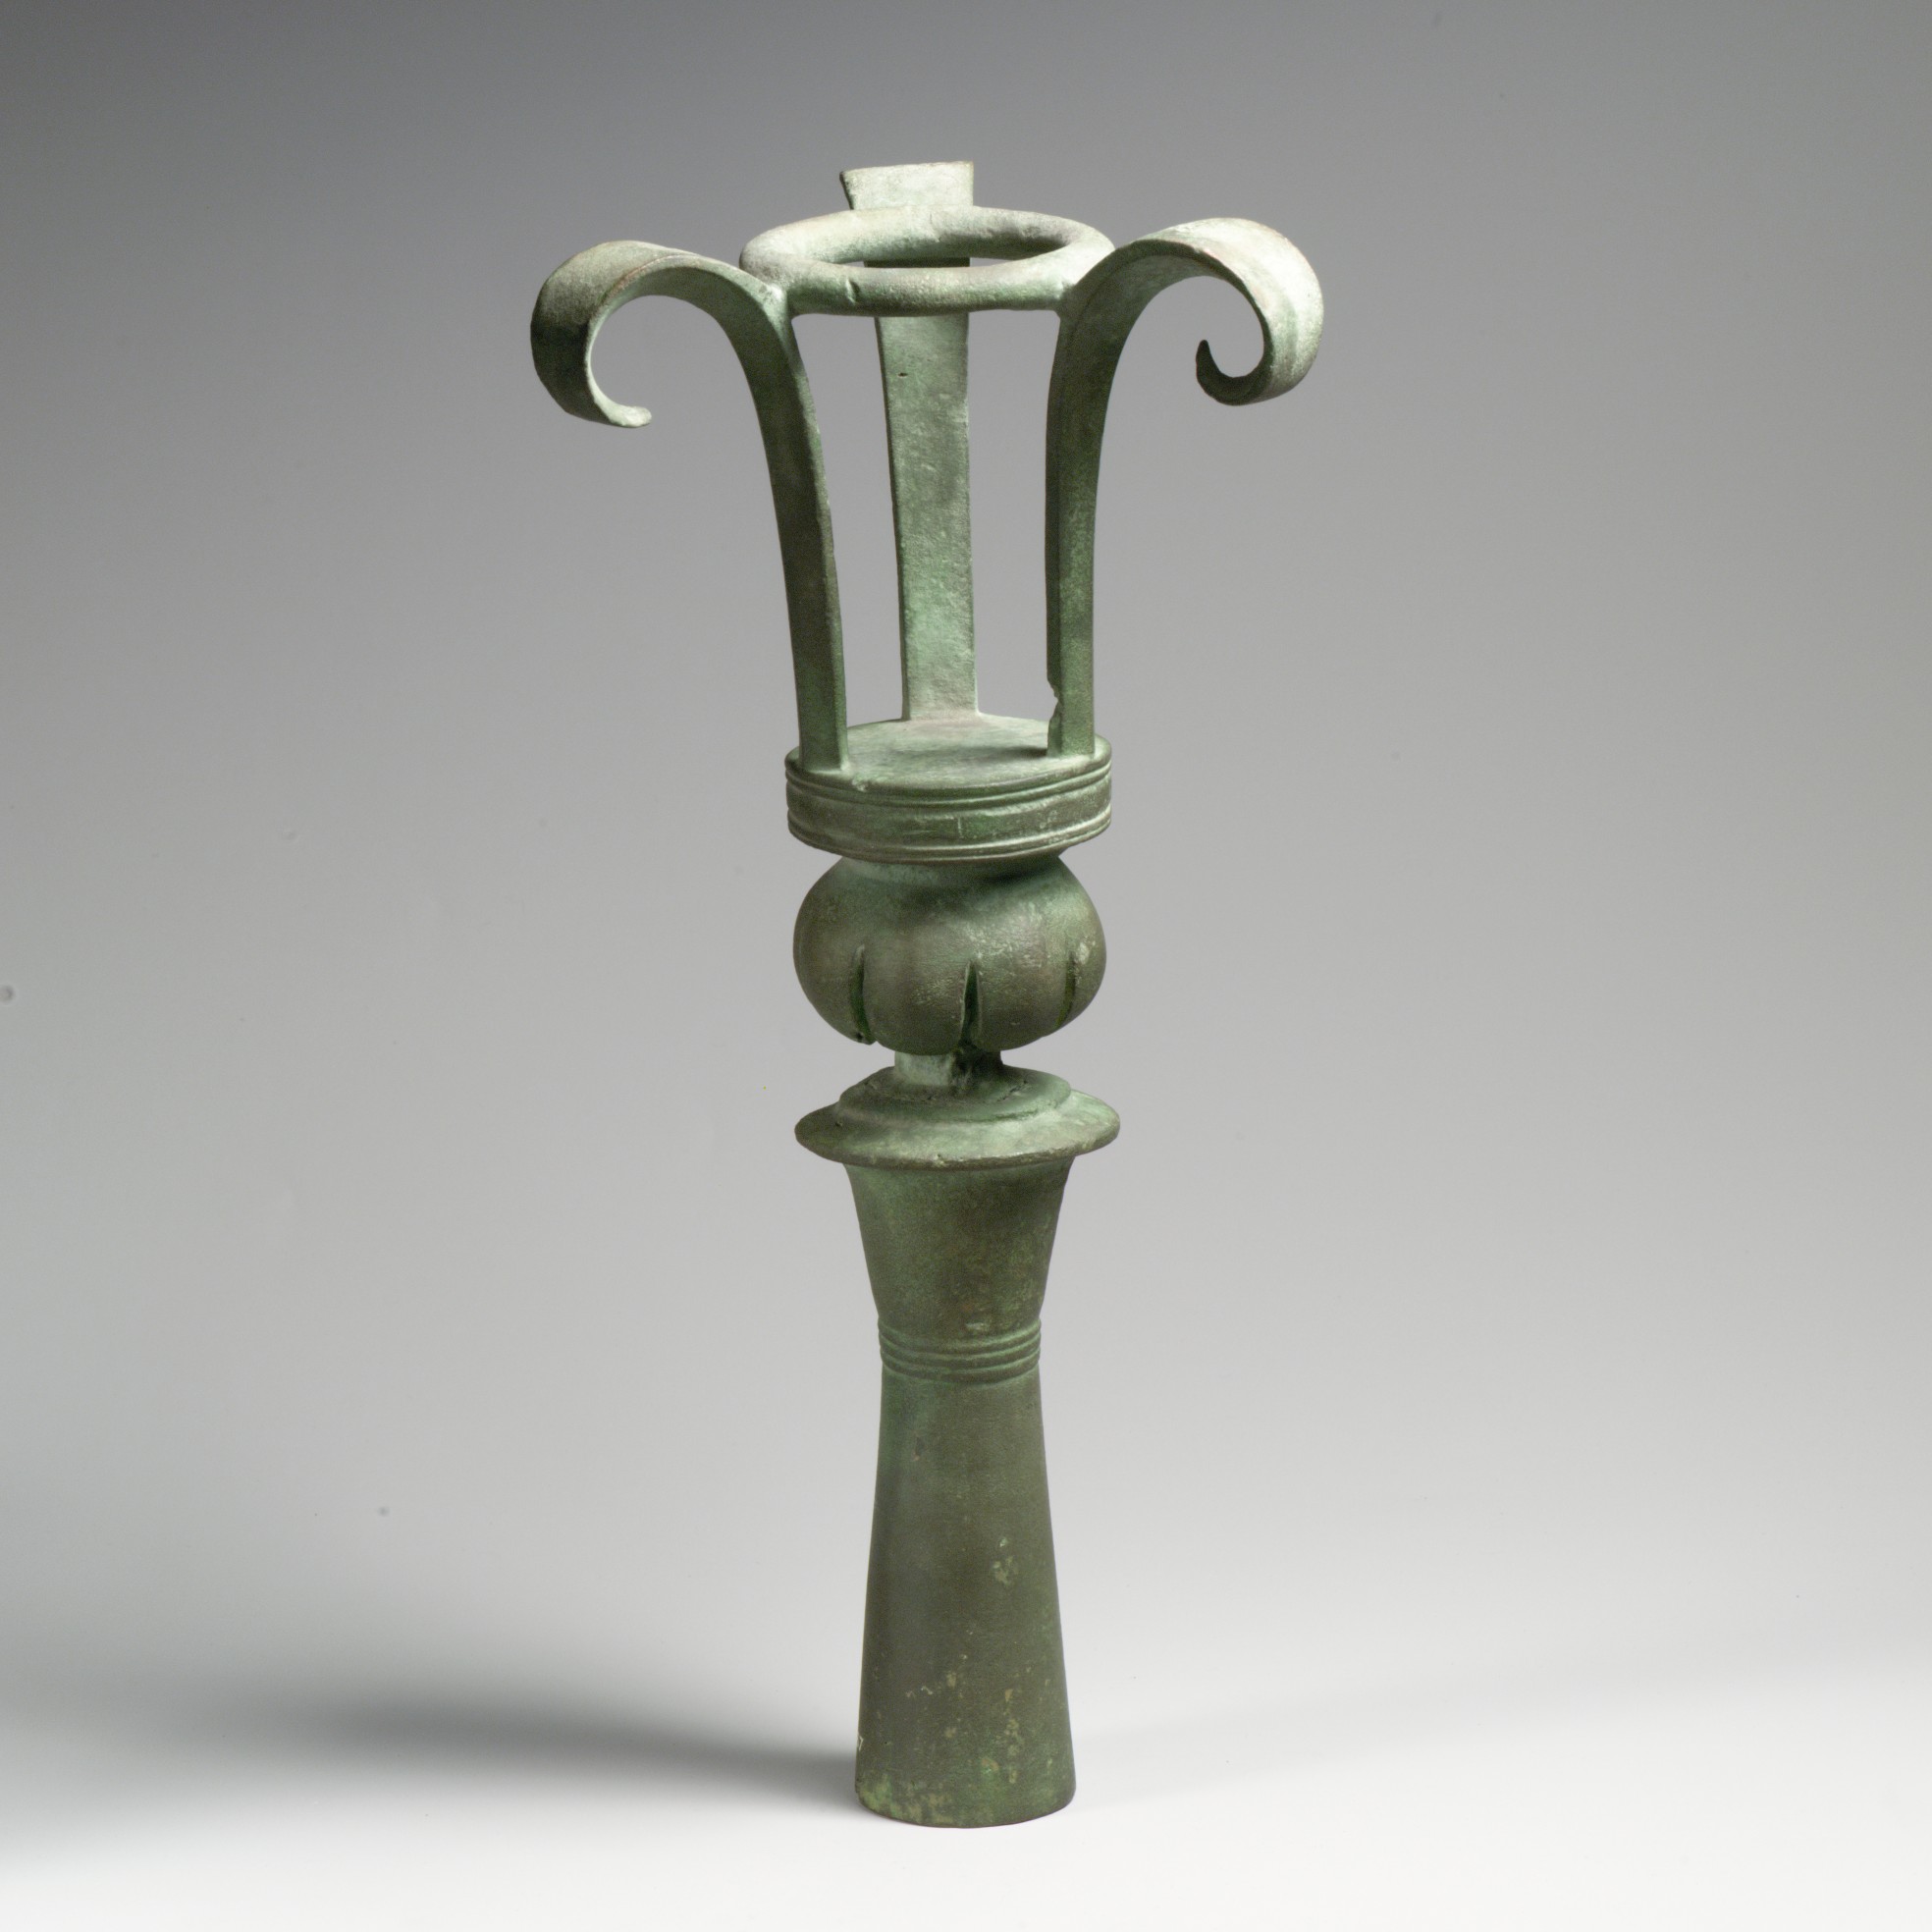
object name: lampstand with lotus petal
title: Bronze lampstand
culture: cypriot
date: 750-480 BCE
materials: bronze